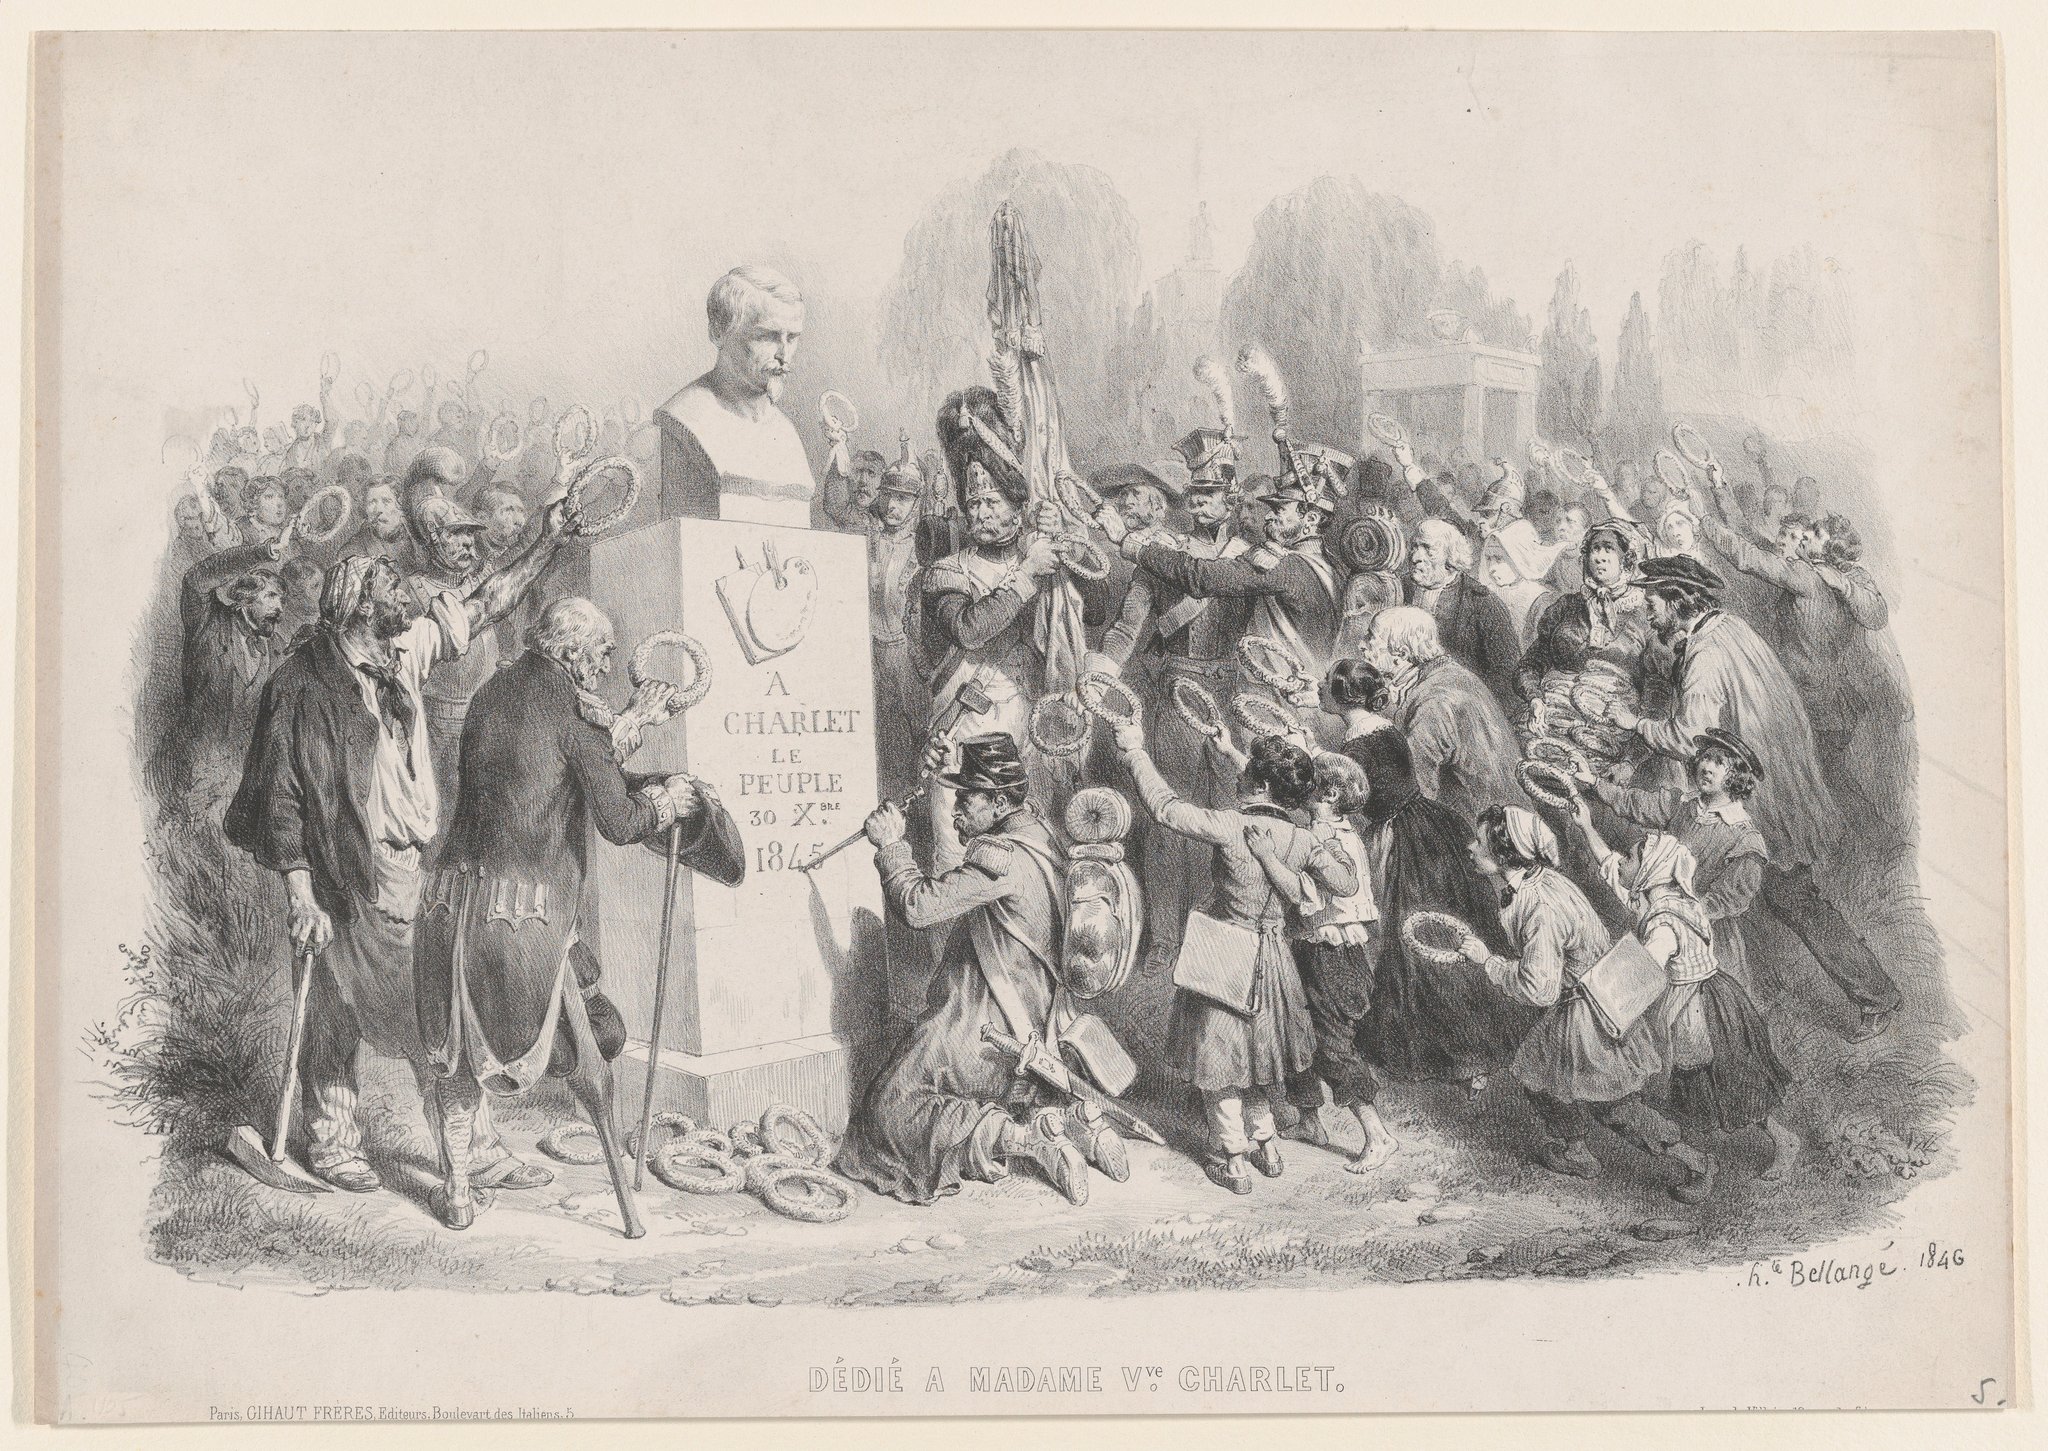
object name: print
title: Dedicated to Madame Vve. Charlet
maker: hippolyte bellangé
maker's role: artist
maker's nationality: french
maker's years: 1800-1866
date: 1846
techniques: lithograph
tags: sculpture,men,crowd,working